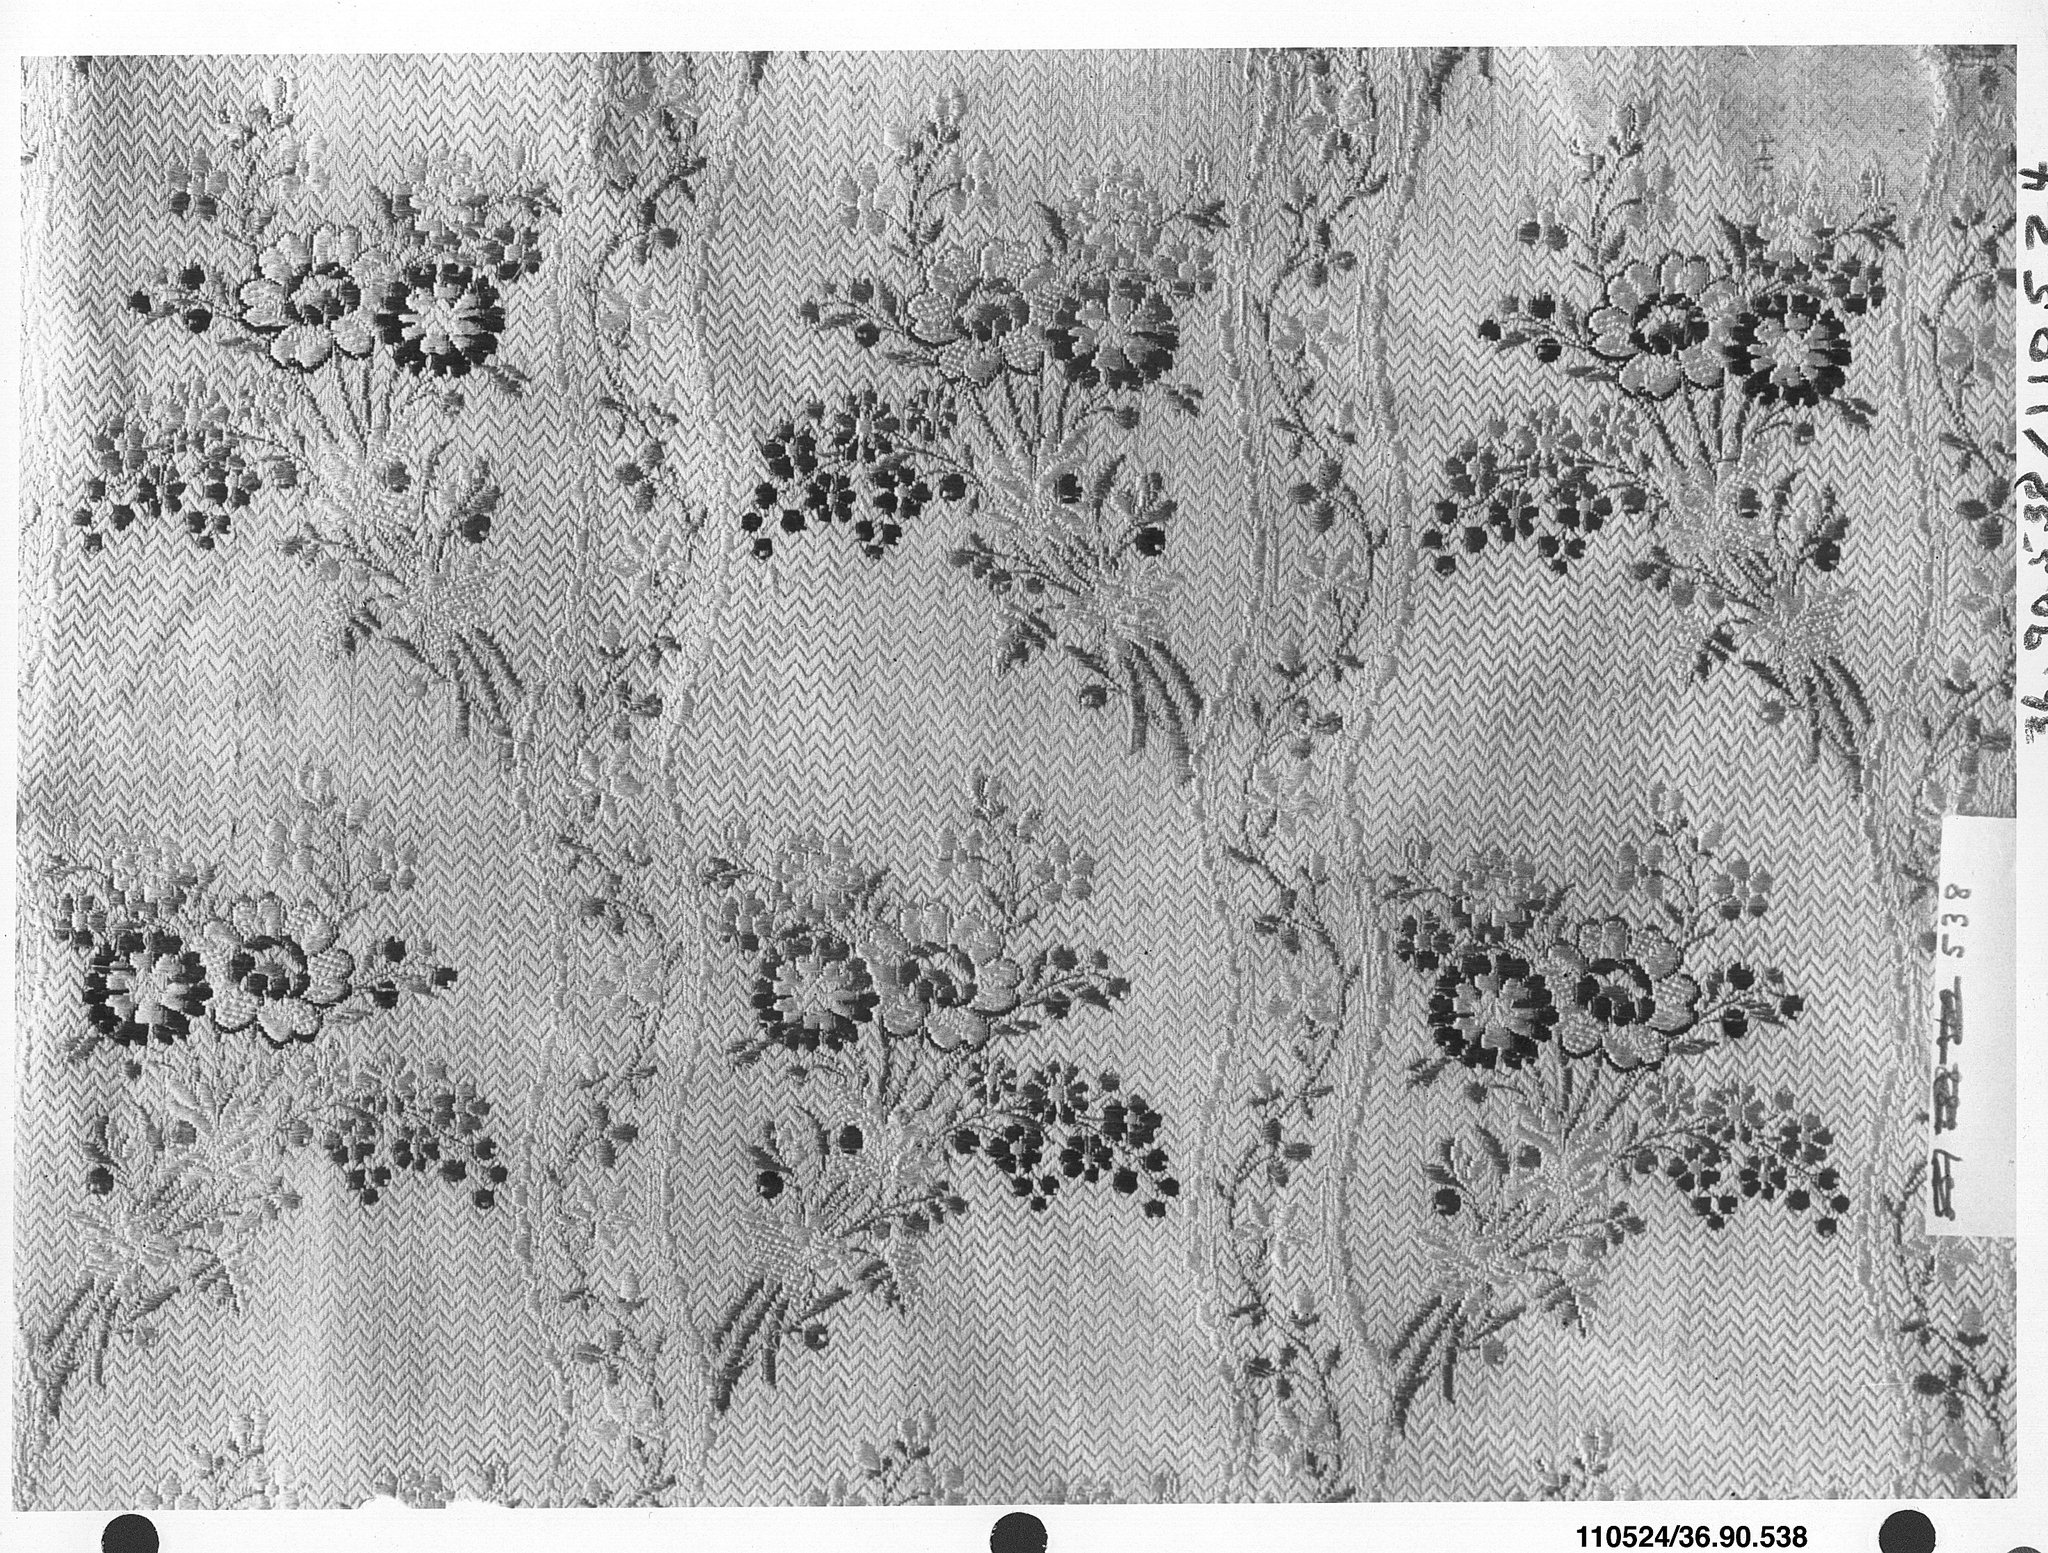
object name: piece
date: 1767-1800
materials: silk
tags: flowers,leaves